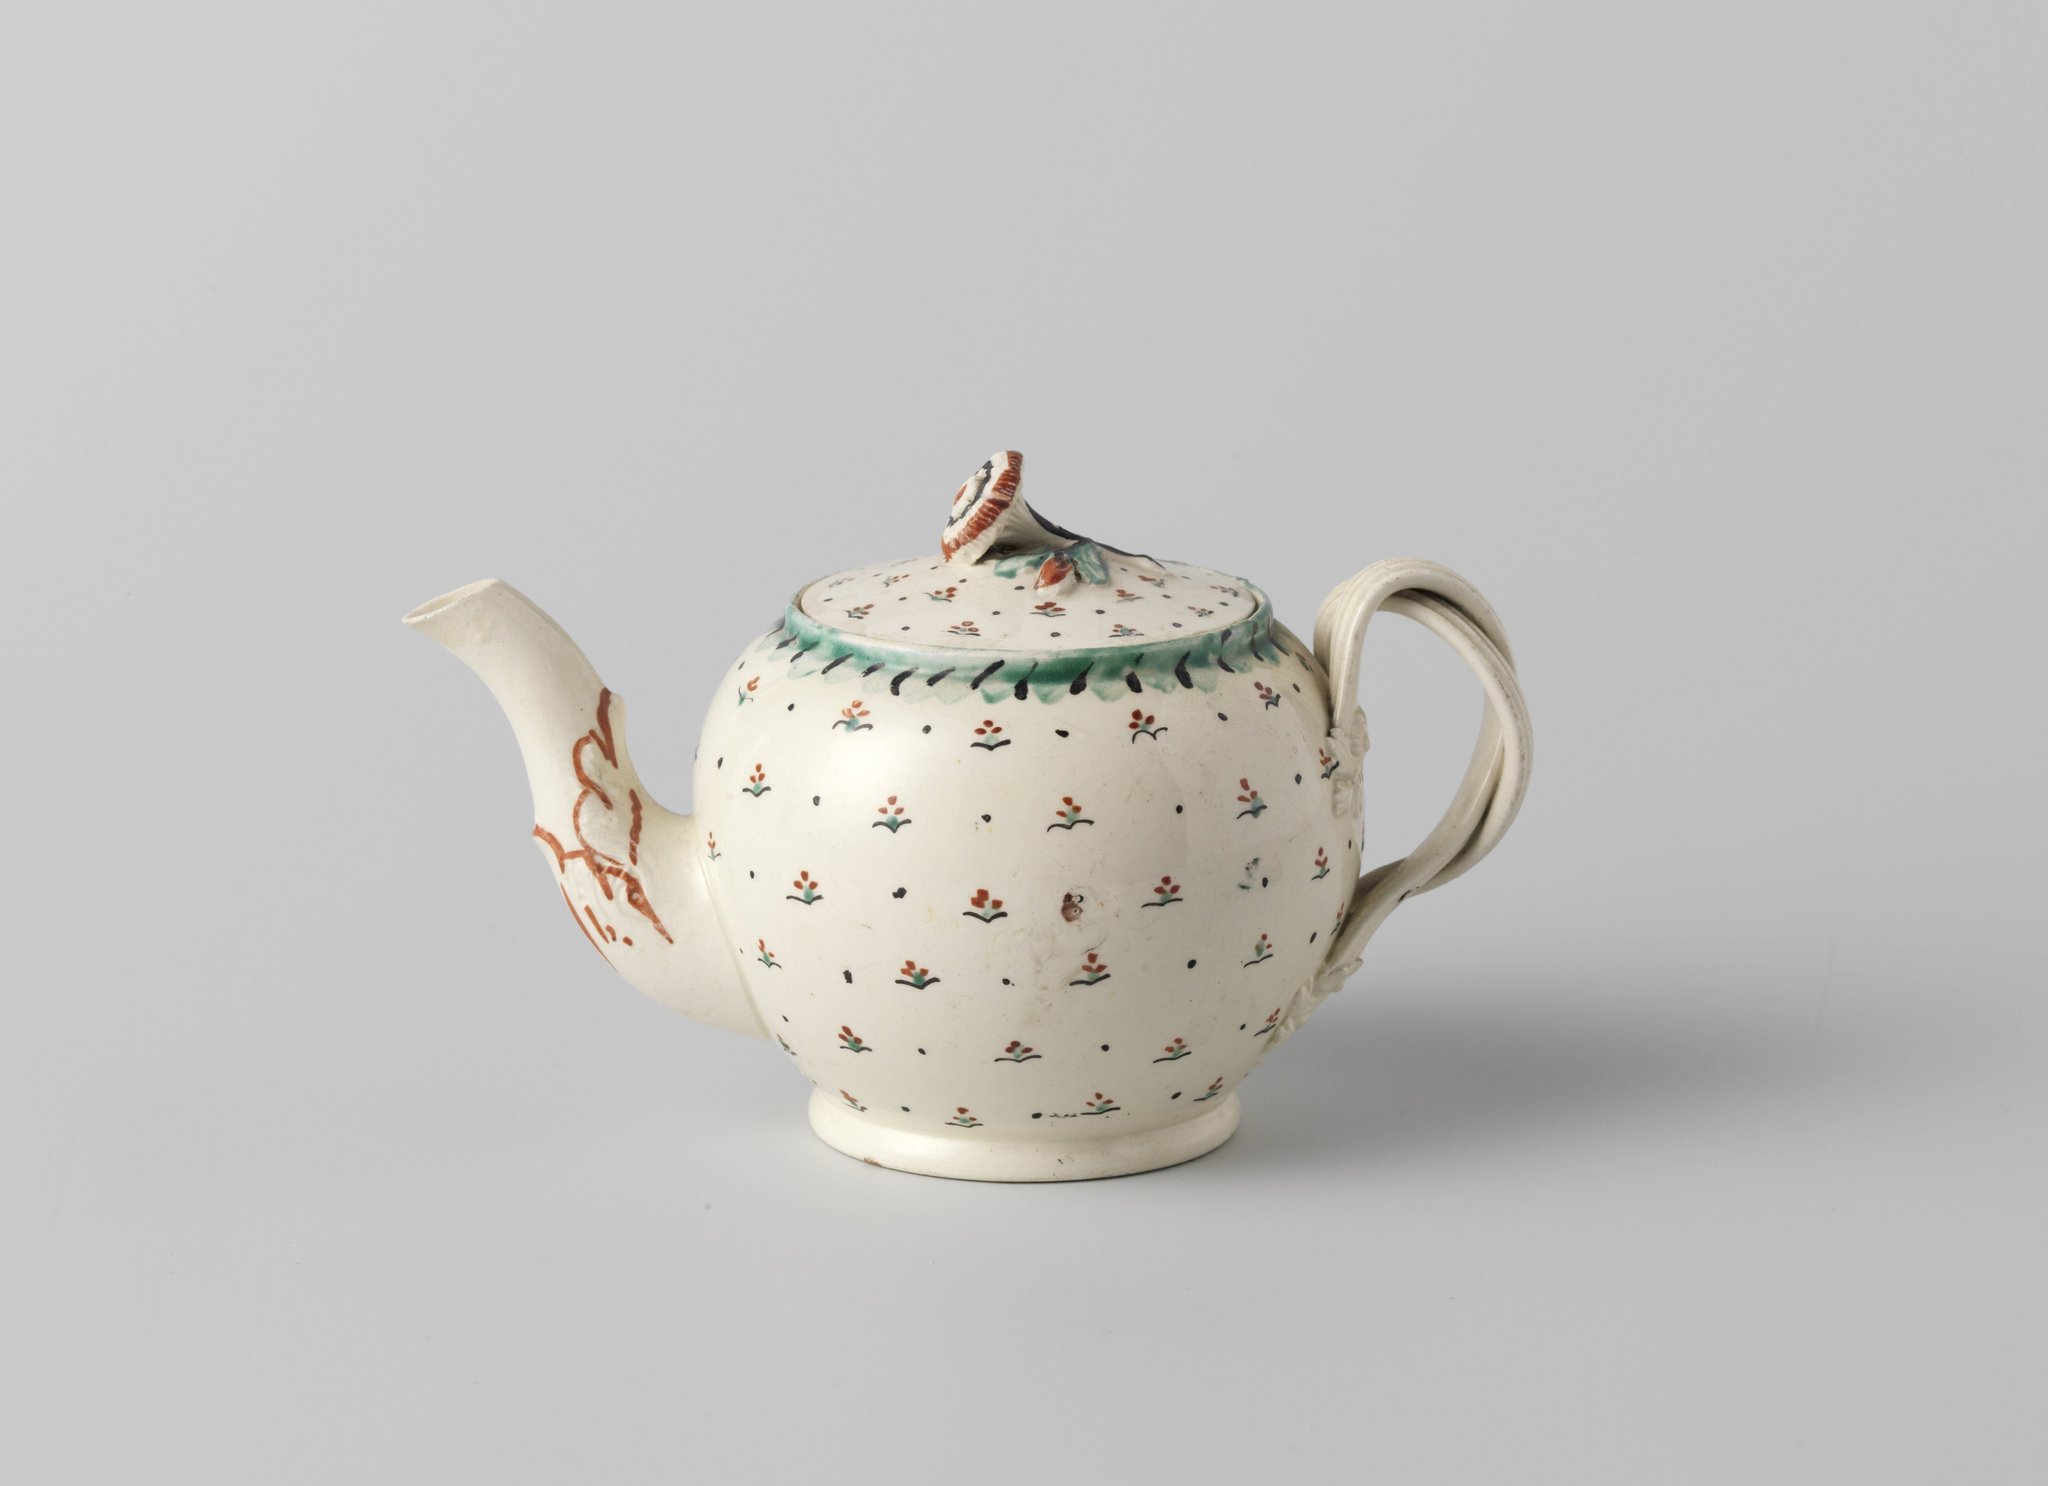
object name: teapot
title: Theepot met deksel van hardgebakken aardewerk met een veelkleurige decoratie op de glazuur, creamware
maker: Anonymous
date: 1770-1790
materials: earthenware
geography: england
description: Bolvormige theepot van hardgebakken aardewerk. De theepot heeft een deksel met een bloem als knop, een gevlochten oor een S-vormige tuit. De theepot is in rood, zwart en groen beschilderd met kleine gestileerde bloemen. De tuit heeft bladeren (?) in reliëf.